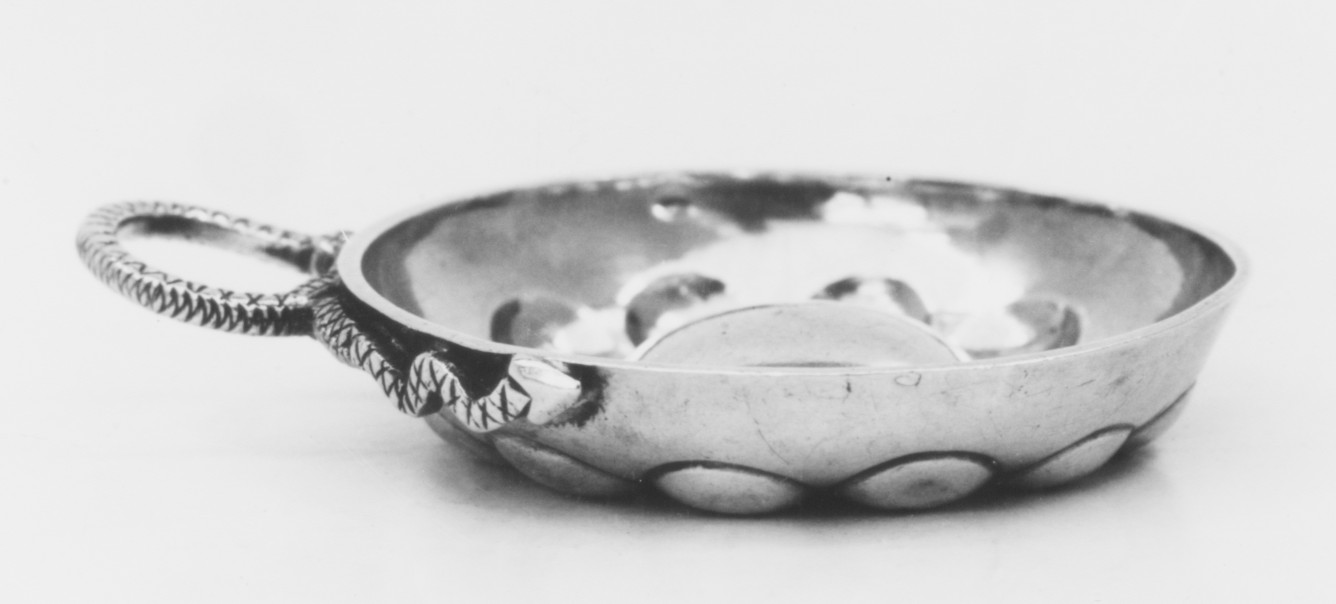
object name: wine taster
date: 1775-1776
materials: silver